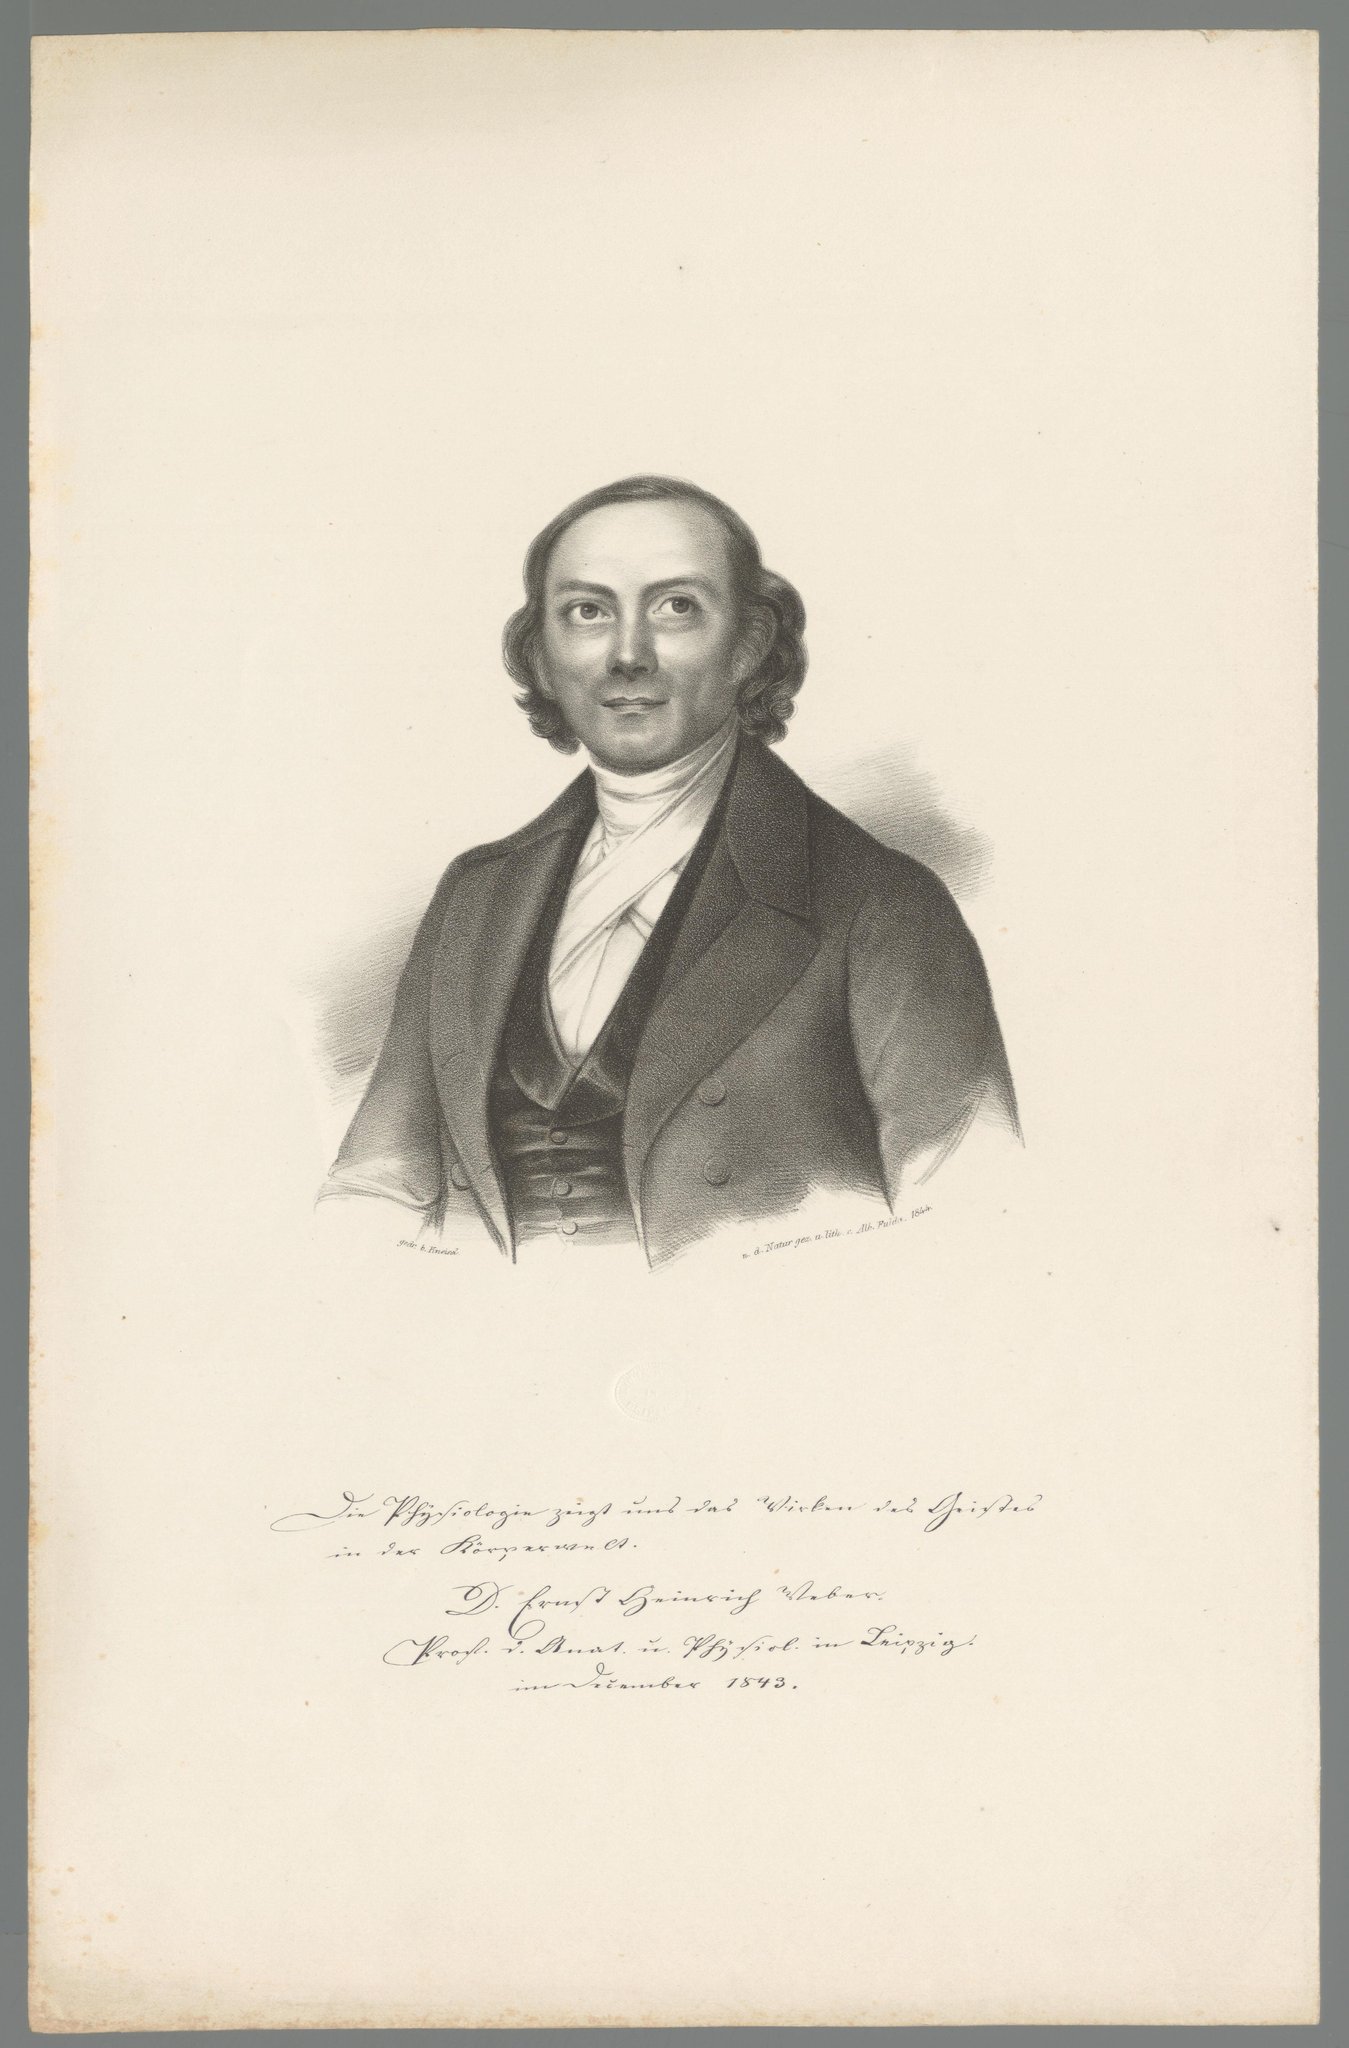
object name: print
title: Portret van Ernst Heinrich Weber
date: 1844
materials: paper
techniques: lithograph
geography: leipzig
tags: adult man, historical persons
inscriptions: collector's mark: Lugt 2228, check stamp: ‘Louis Rocca in Leipzig’